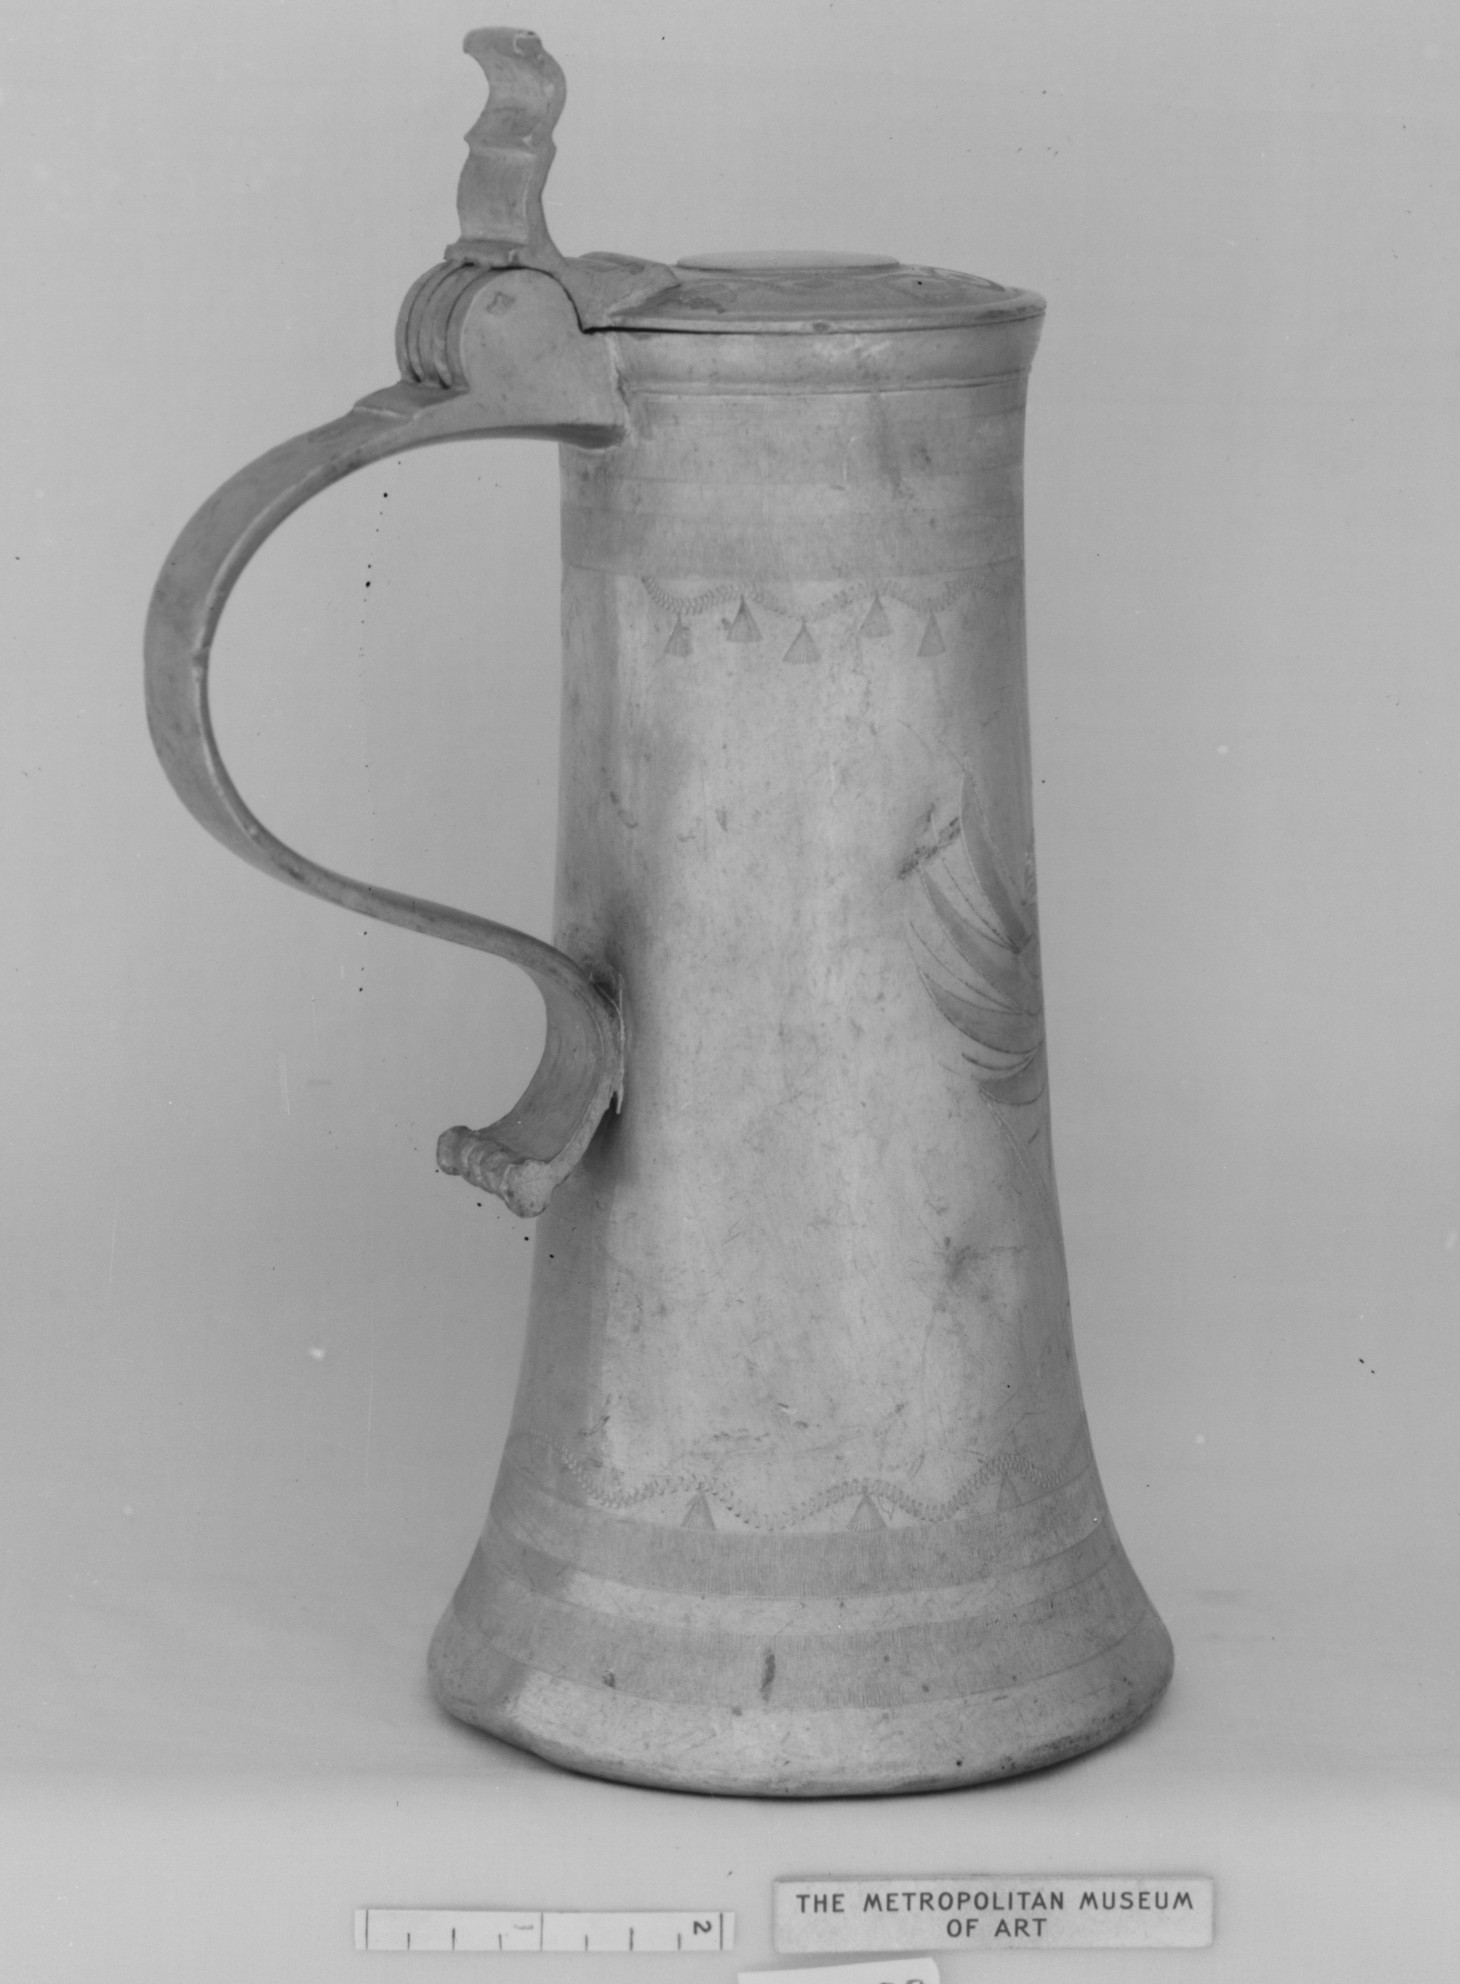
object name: flagon or tankard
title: Tankard or flagon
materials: pewter